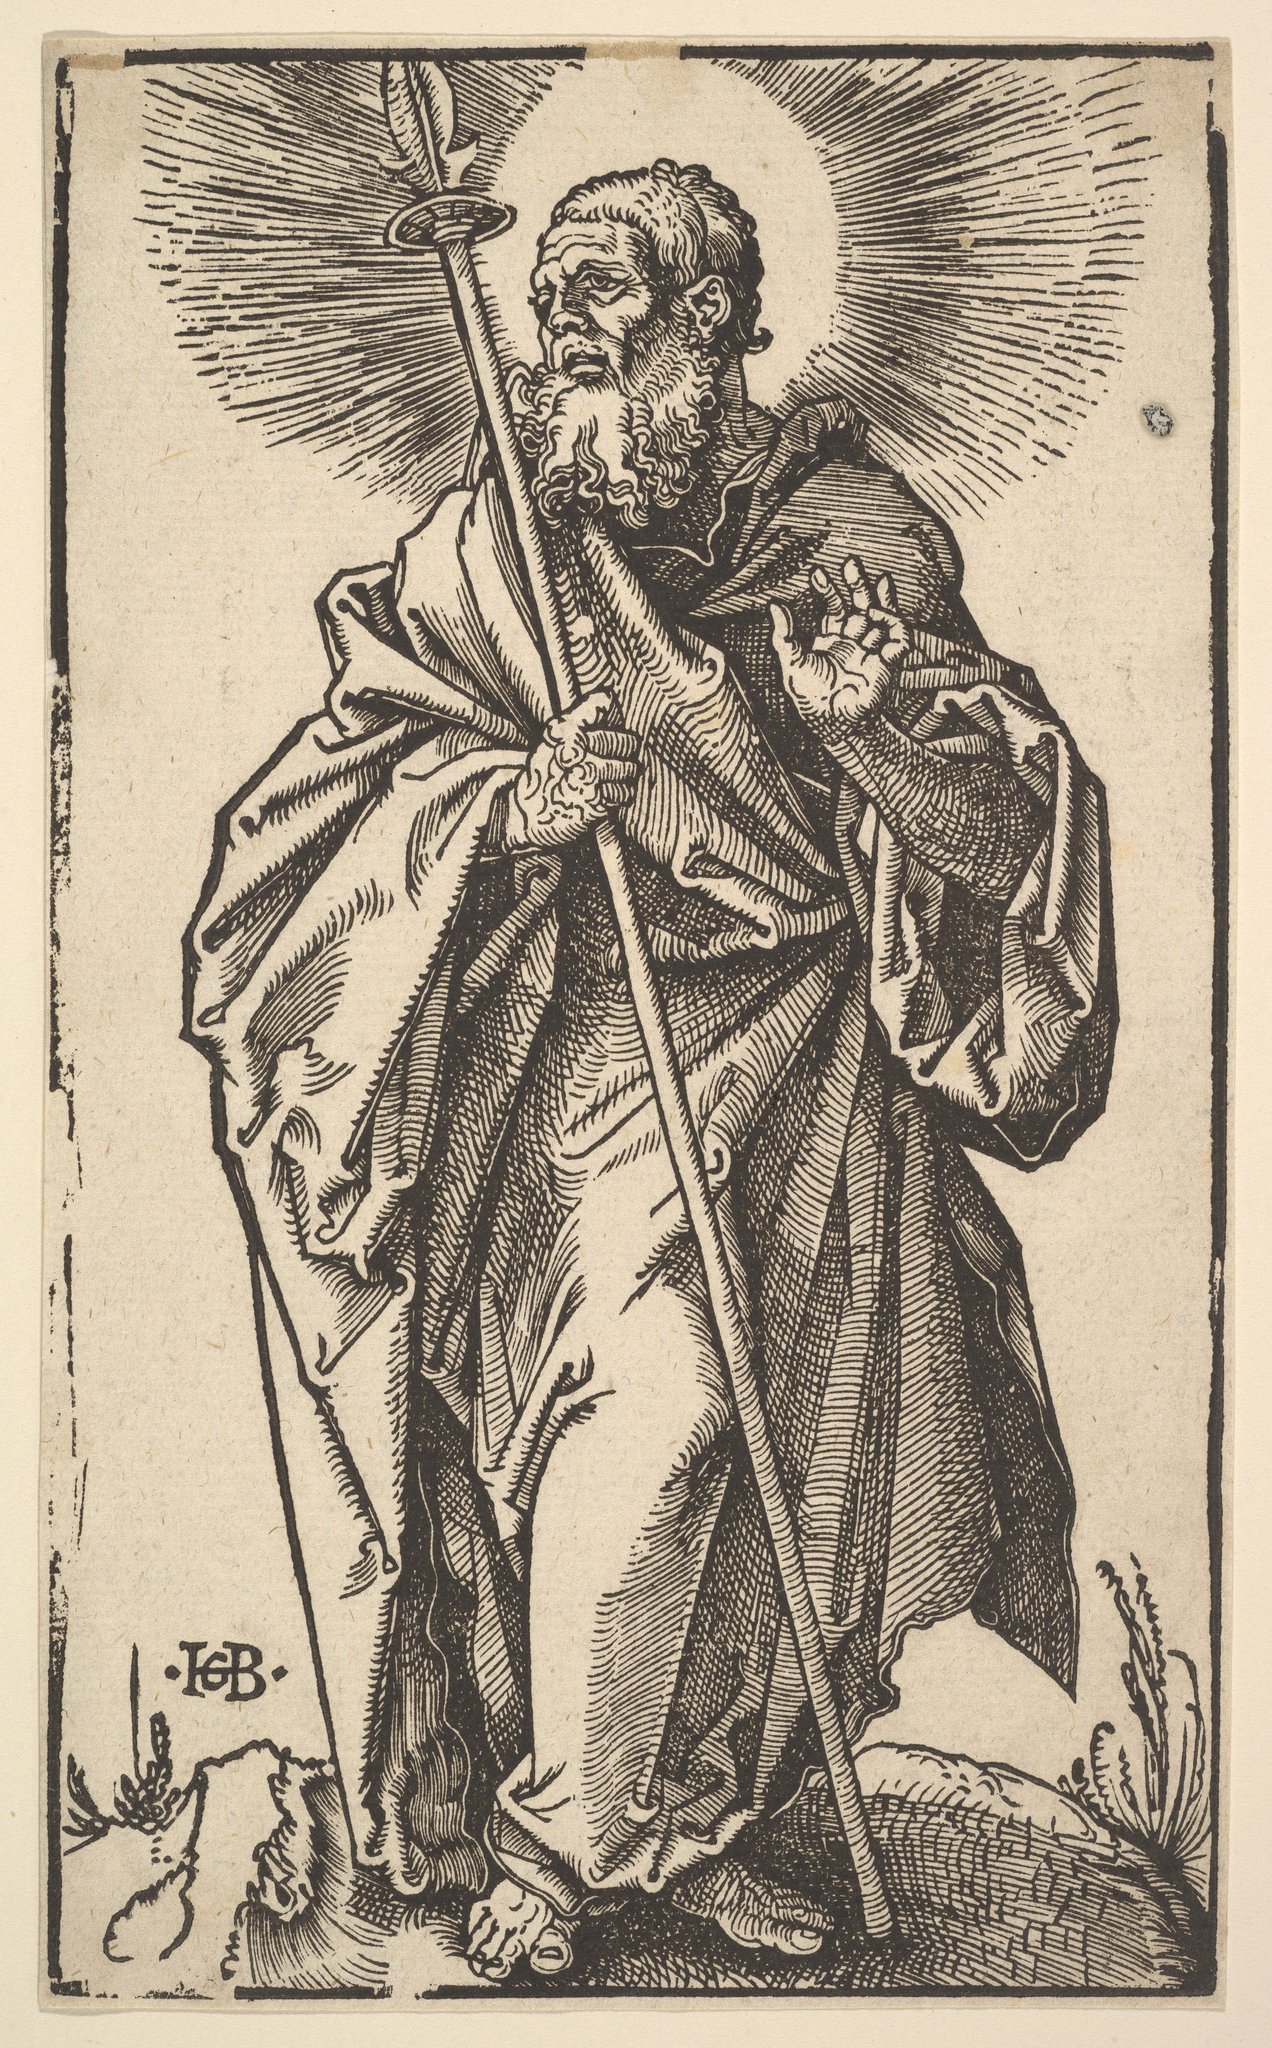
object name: print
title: Saint Thomas, from "Christ and the Apostles"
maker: hans baldung (called hans baldung grien)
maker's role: artist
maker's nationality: german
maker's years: 1484-1545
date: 1519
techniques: woodcut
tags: portraits,saints